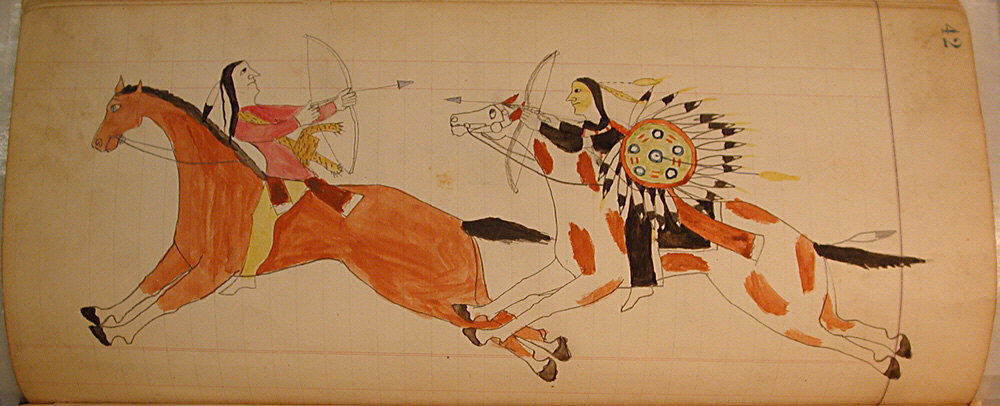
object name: drawing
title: Maffet Ledger: Two Indians on horseback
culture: cheyenne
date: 1874-1881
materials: crayon, graphite, paper, watercolor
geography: united states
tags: bow and arrow,men,horses